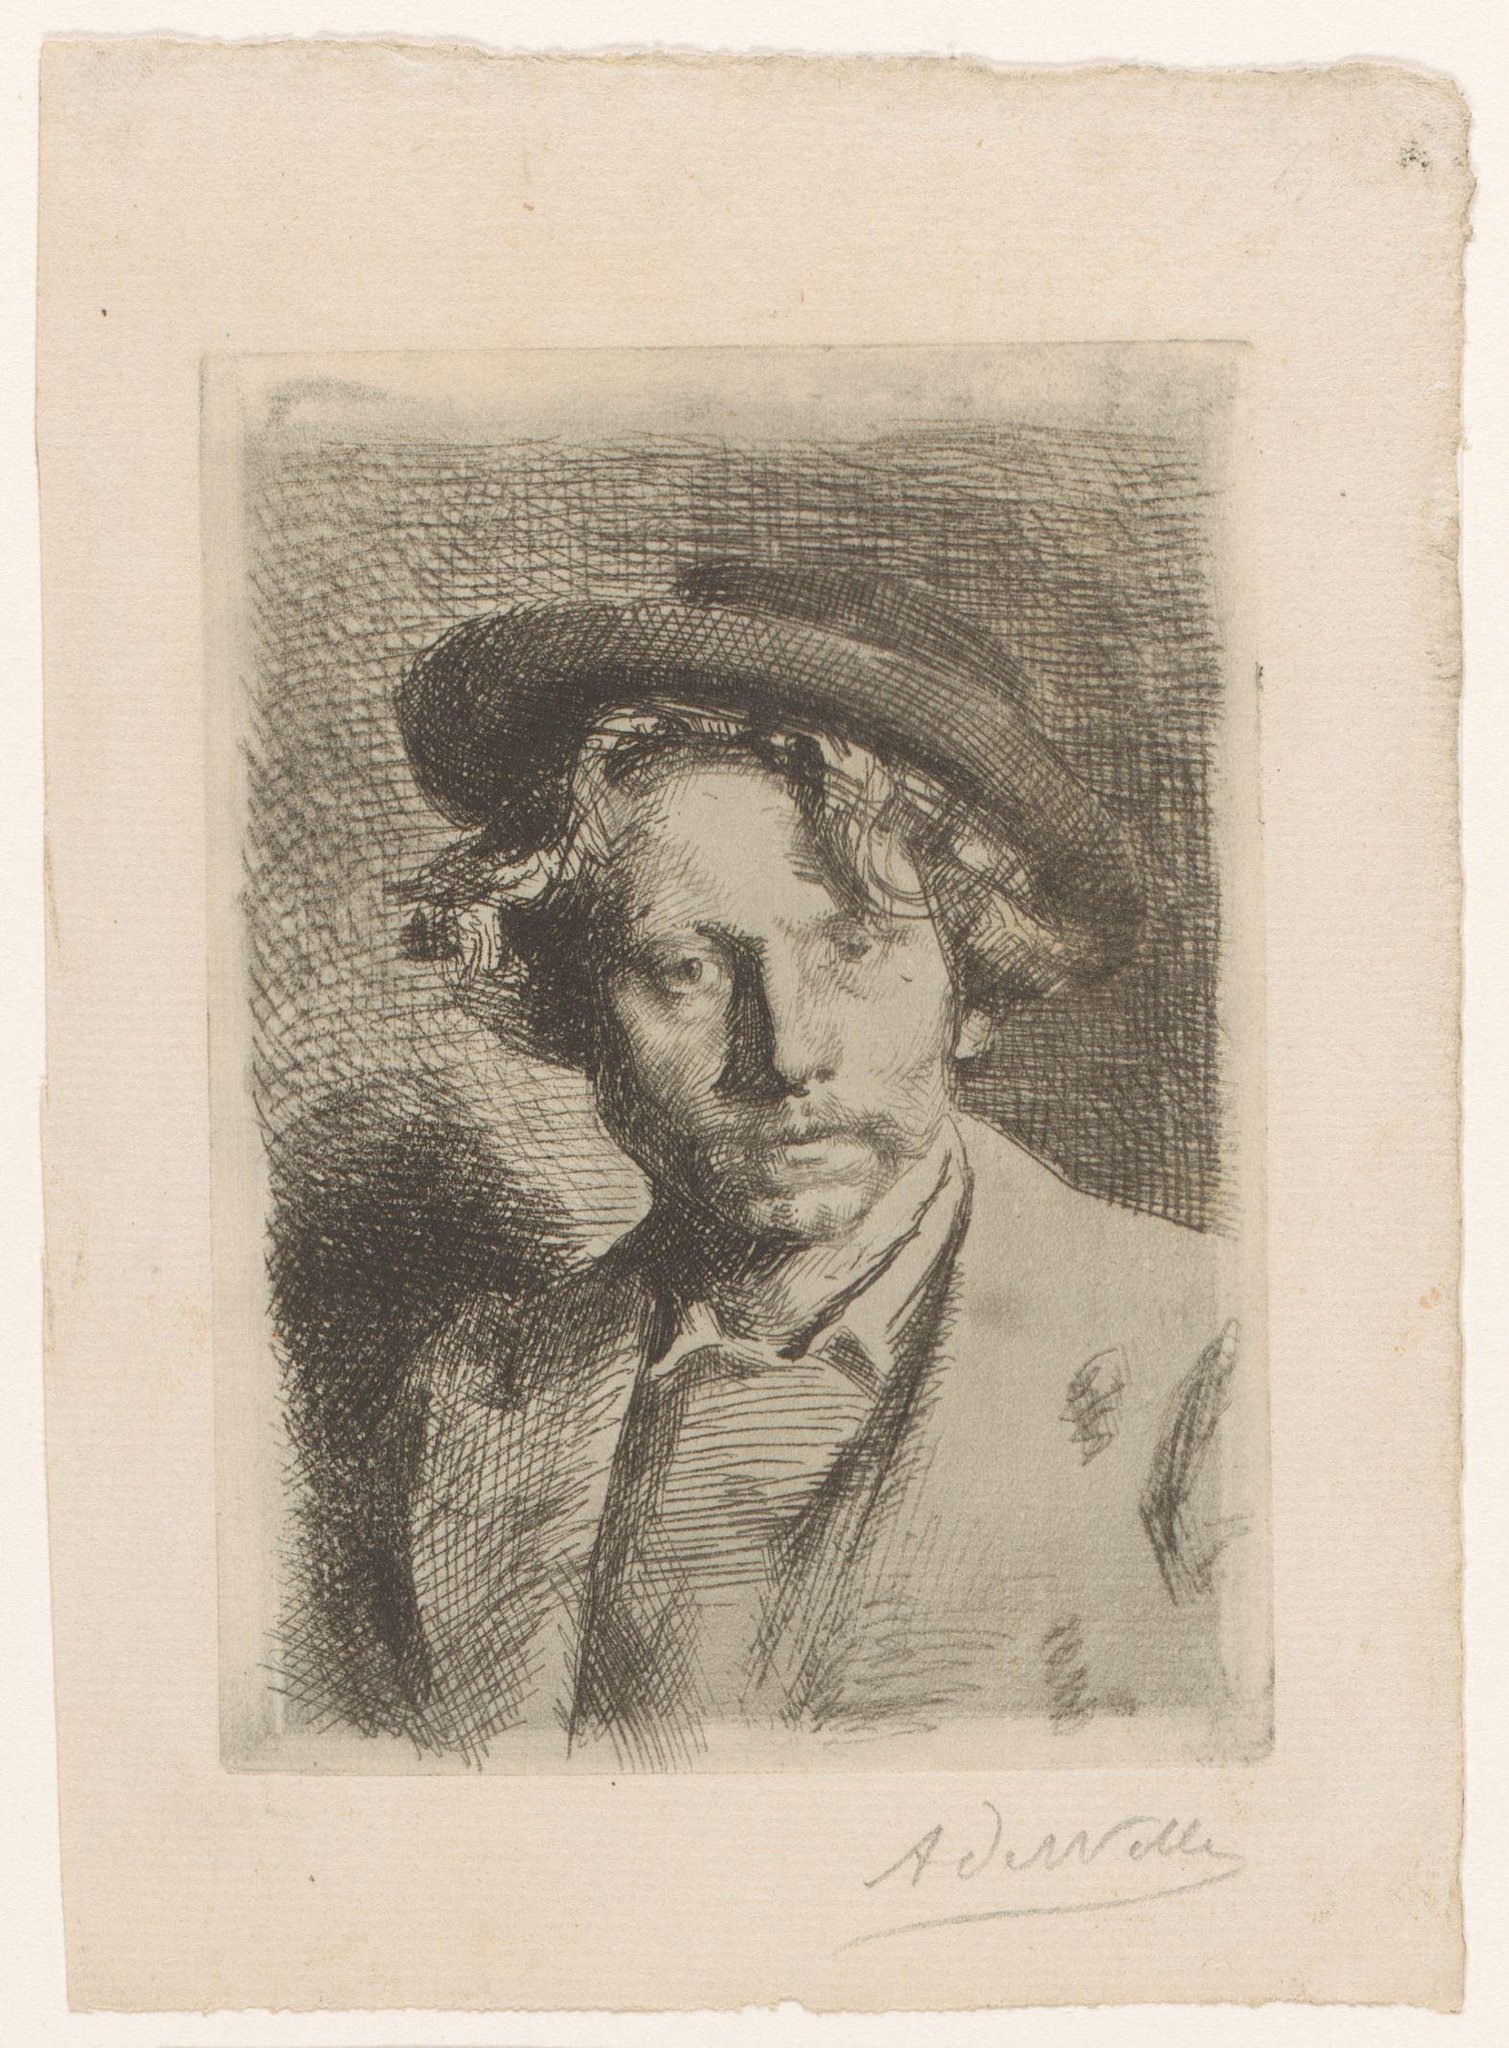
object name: print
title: Portret van Léon-Hubert Zeyen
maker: adrien de witte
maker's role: print maker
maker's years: 1850-1935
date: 1876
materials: paper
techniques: etching, intaglio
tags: liège, léonard hubert zeyen, adult man, historical persons, head-gear: hat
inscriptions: collector's mark: Lugt 2228